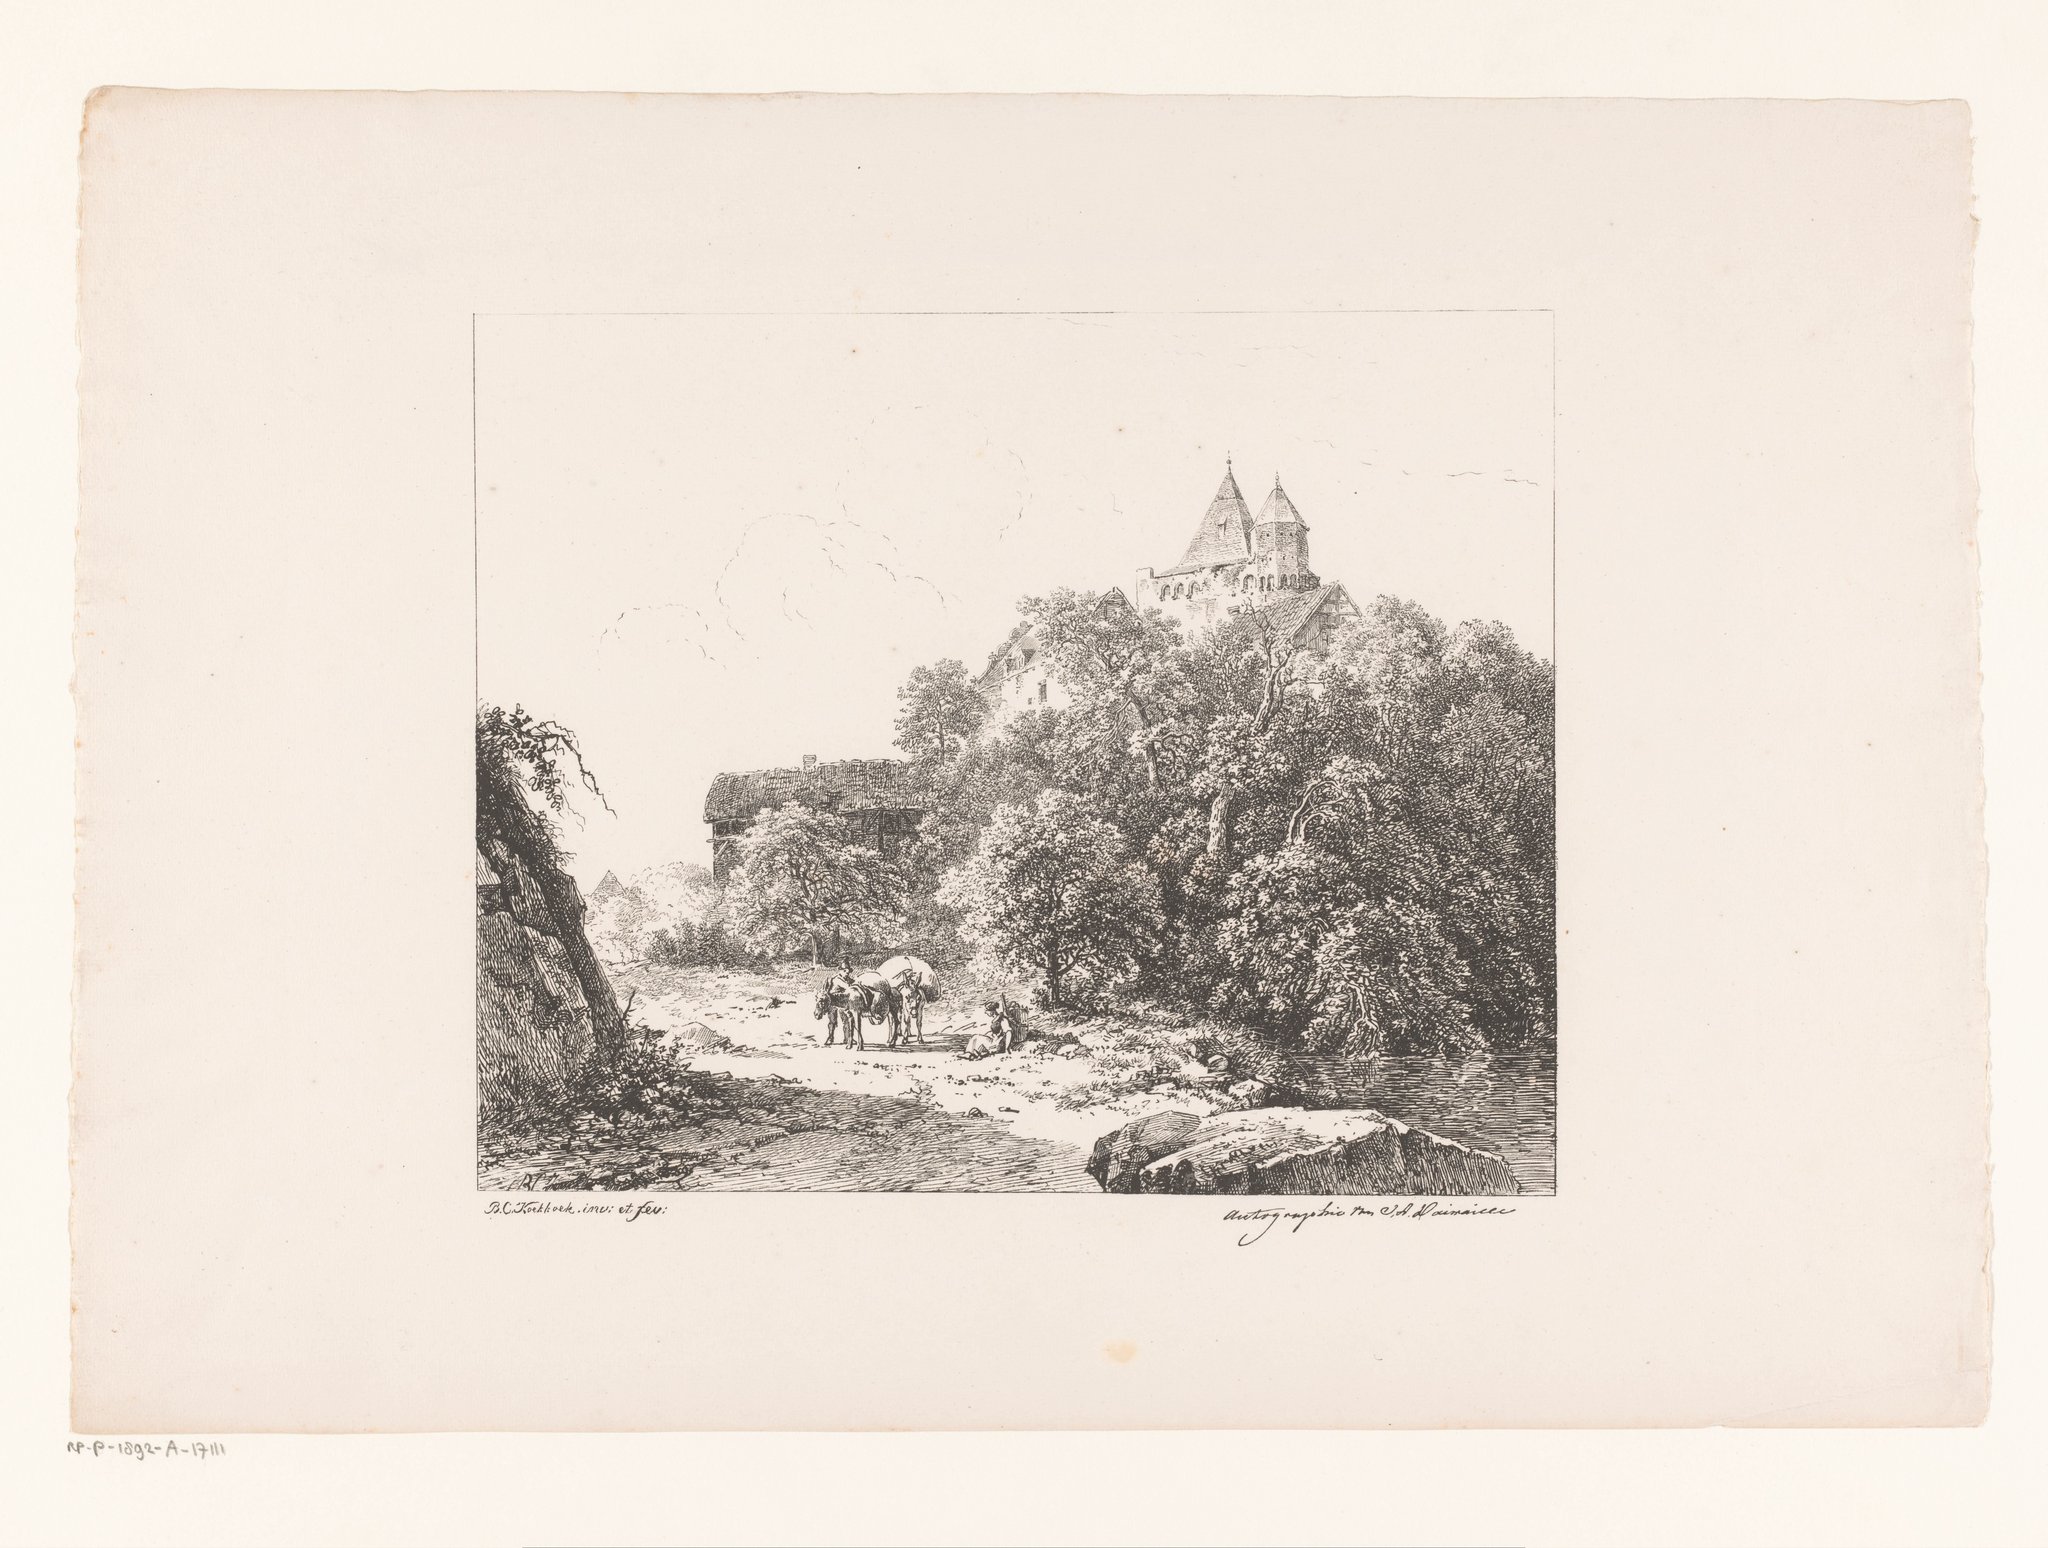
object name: print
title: Chateau Lansberg près de Ketwitch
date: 1820-1833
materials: paper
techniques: lithograph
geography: amsterdam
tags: castle, landscape with tower or castle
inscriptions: collector's mark: Lugt 2228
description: Het woord 'autographie' rechtsonder op de prent verwijst, volgens C. J. de Bruyn Kops in het Bulletin van het Rijksmuseum, naar een techniek waarbij op glad papier werd getekend. Deze tekening werd vervolgens op de steen overgebracht. Tot slot werd hiermee gedrukt. Dit had het effect dat de afbeelding niet in spiegelbeeld werd afgedrukt en de tekenaar dus ook niet in spiegelbeeld hoefde te werken.